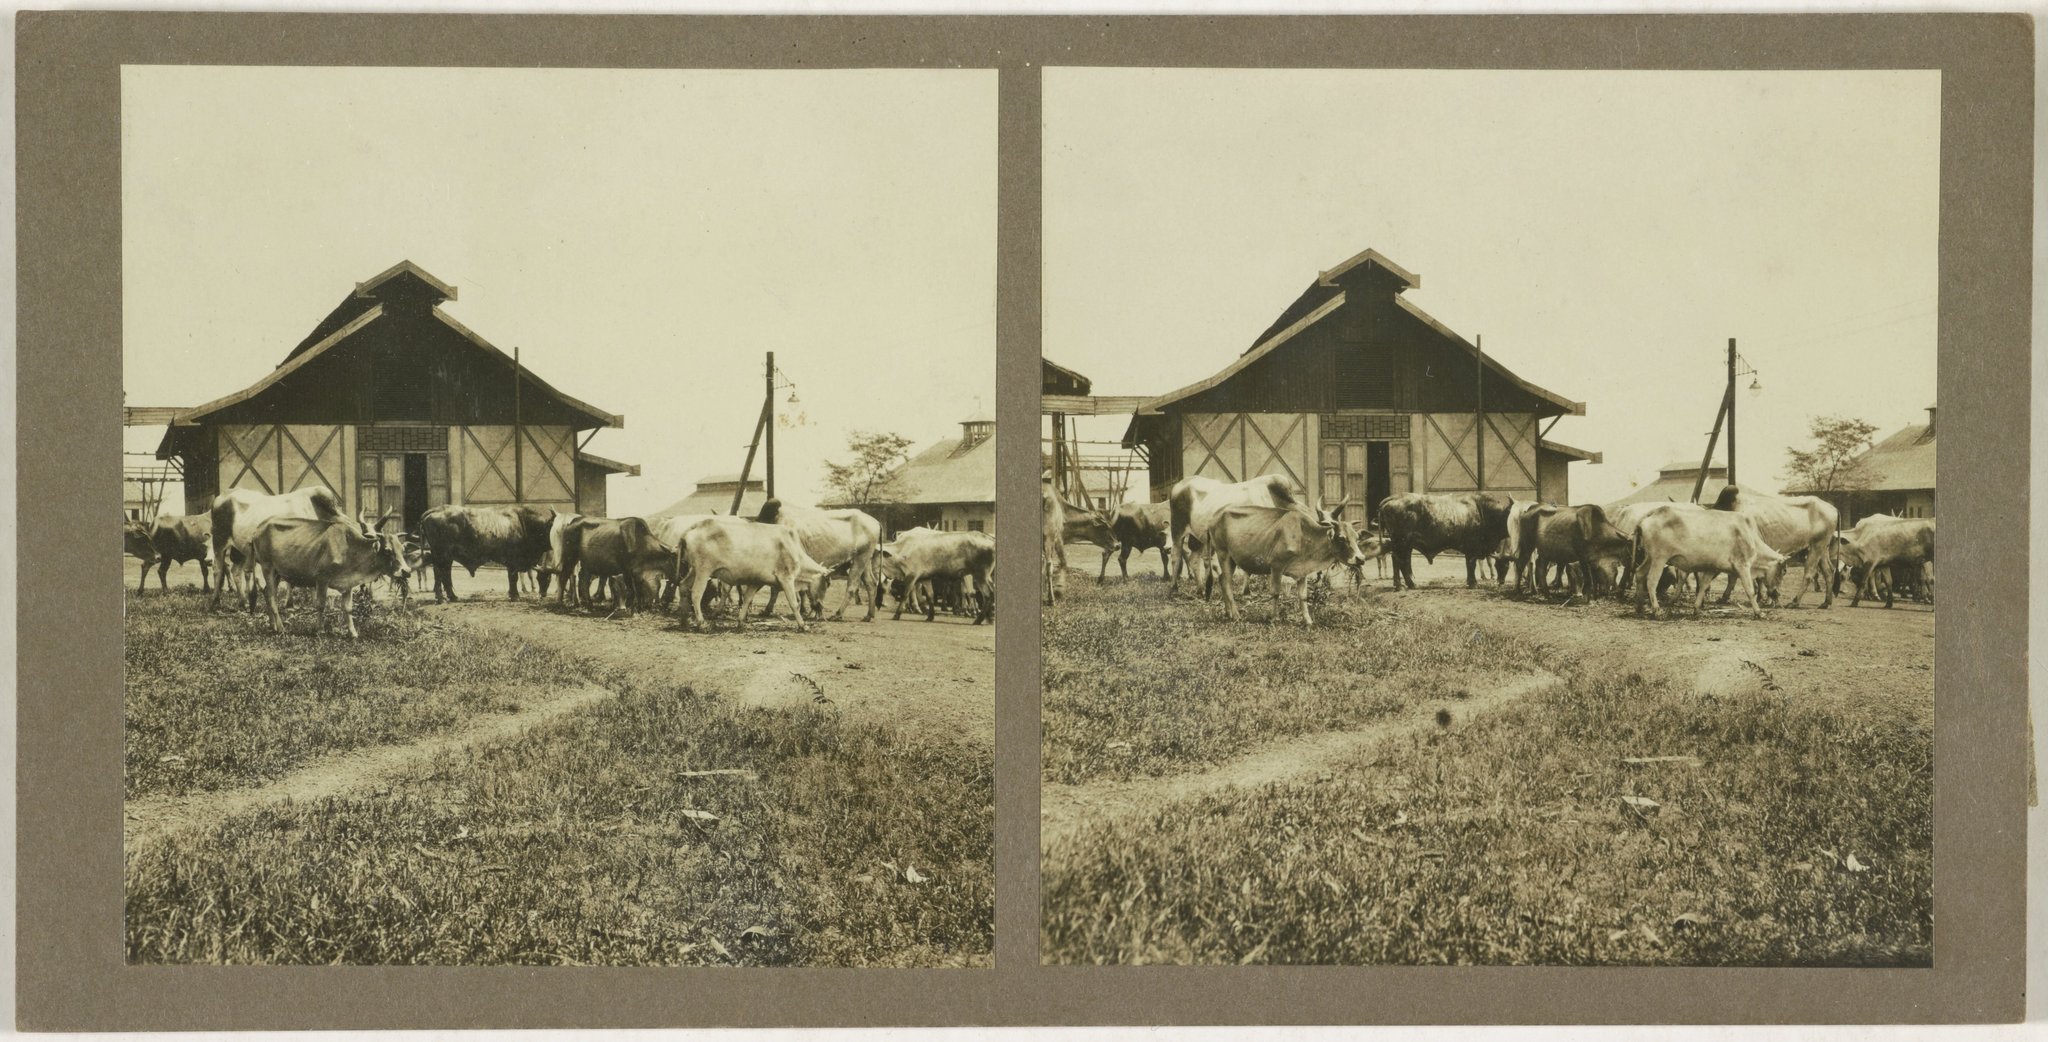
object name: stereograph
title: Loslopende koeien op een erf, mogelijk op Borneo, Indonesië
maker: Anonymous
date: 1900-1940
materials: paper, cardboard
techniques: gelatin silver print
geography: indonesia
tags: cow, indonesia